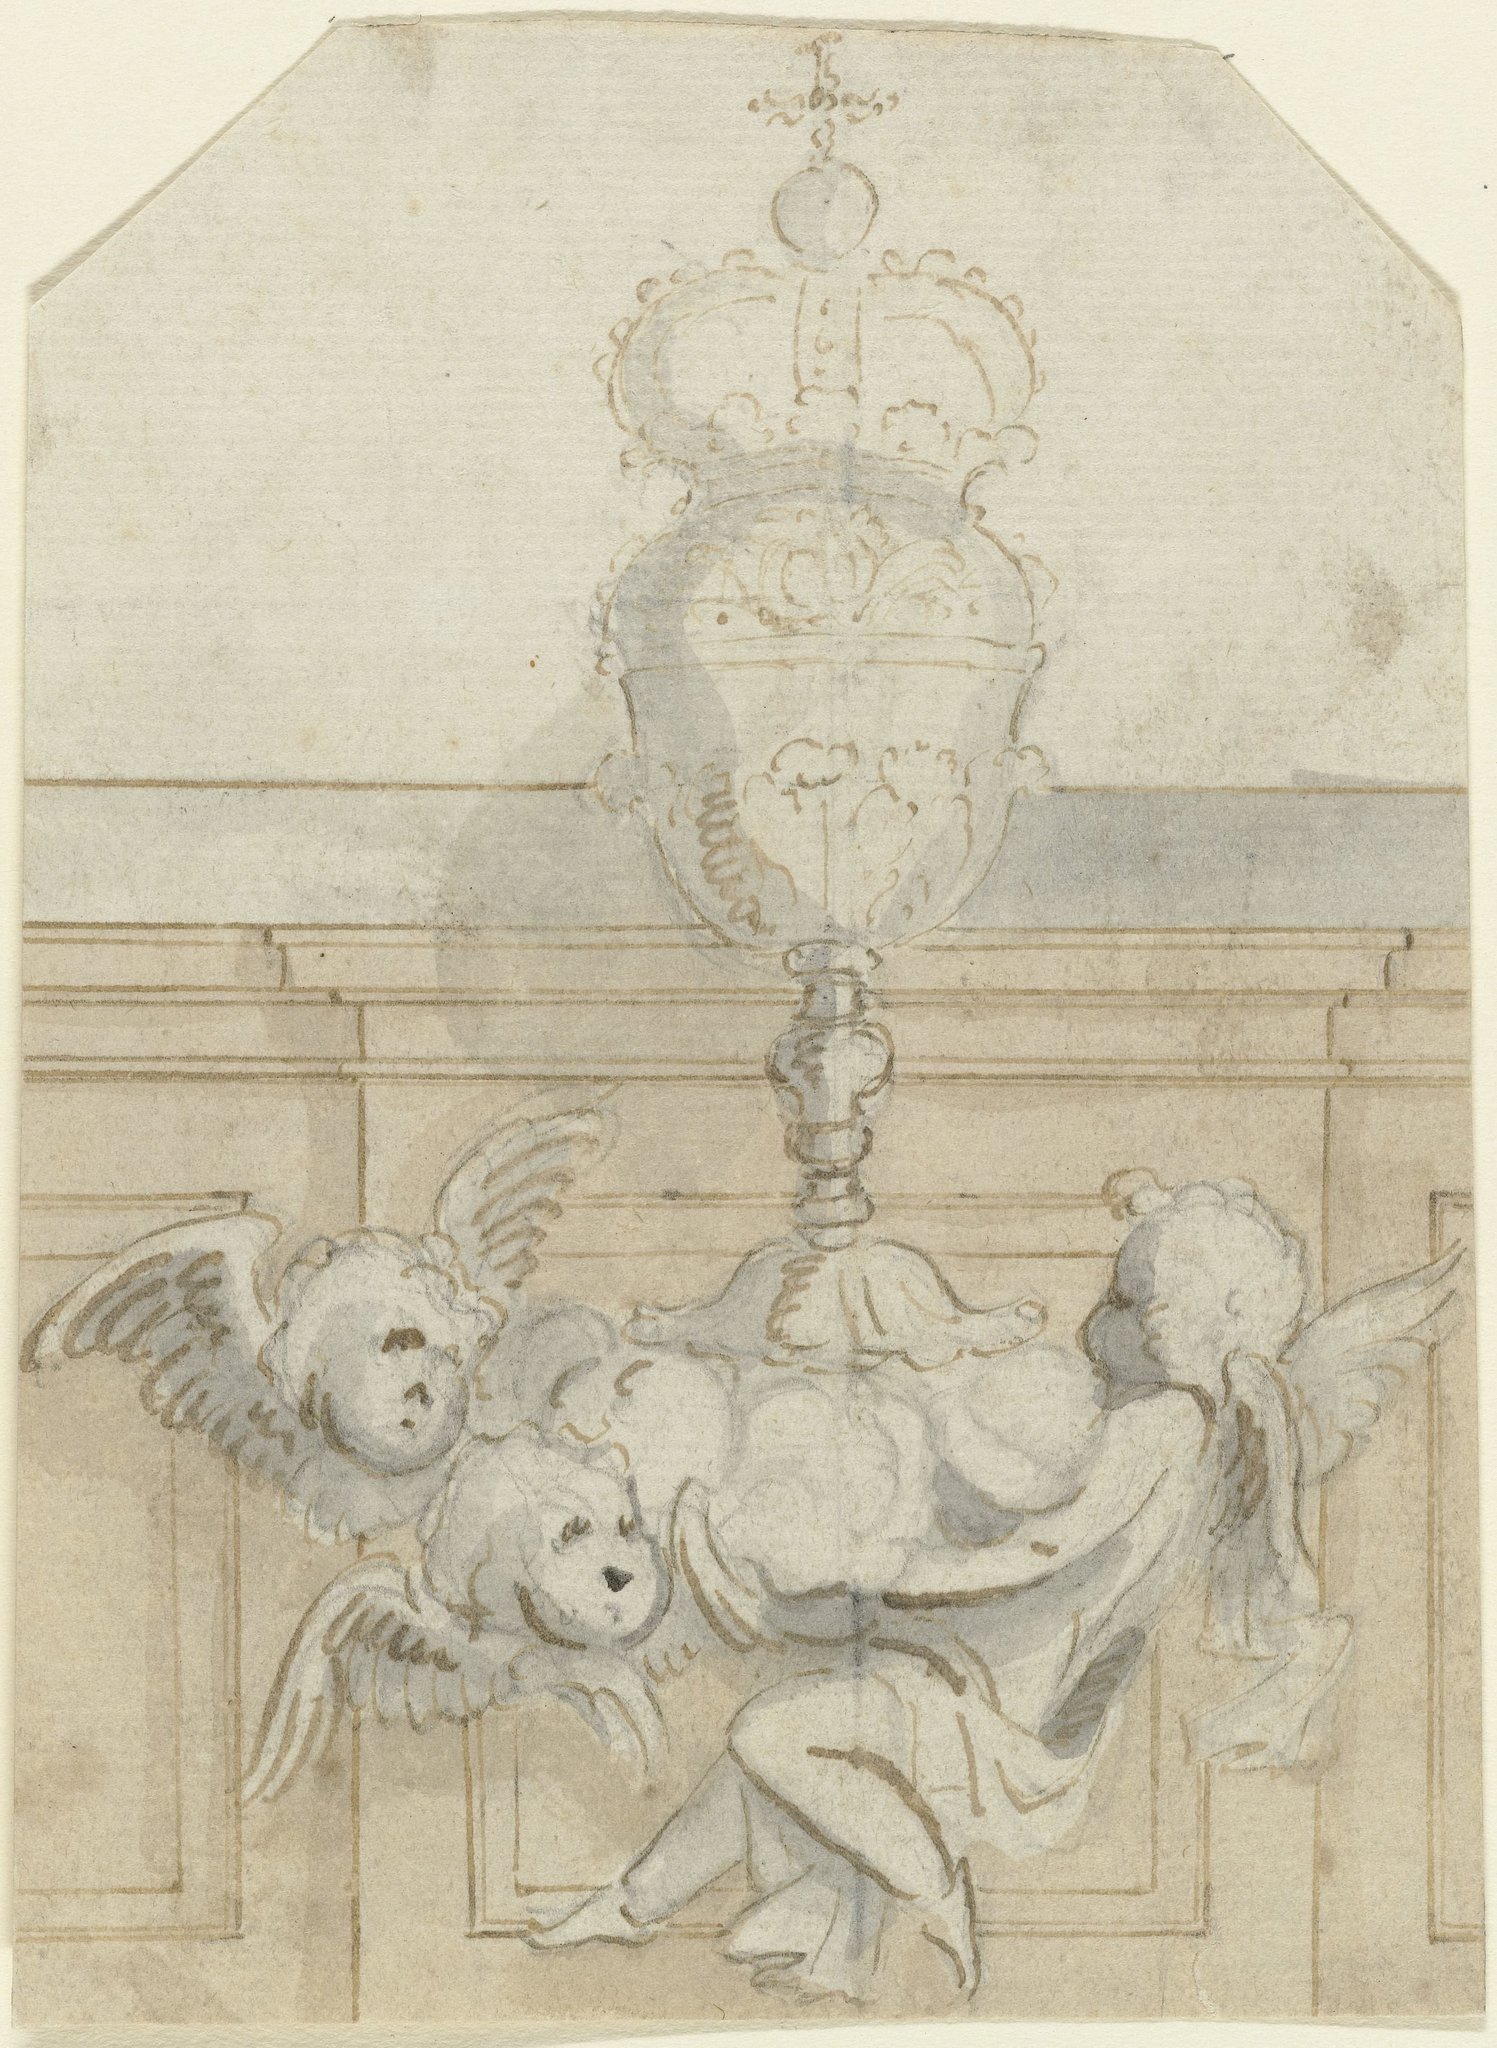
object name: drawing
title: Putto en cherubijnen met pronkbeker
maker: Anonymous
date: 1600-1800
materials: ink, paper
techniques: brush, pen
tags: cherubs, i.e. children's heads with wings, chalice, angel(s) represented as child(ren)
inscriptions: collector's mark: Lugt 2228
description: Een putto en cherubijnen met een pronkbeker met koningskroon.